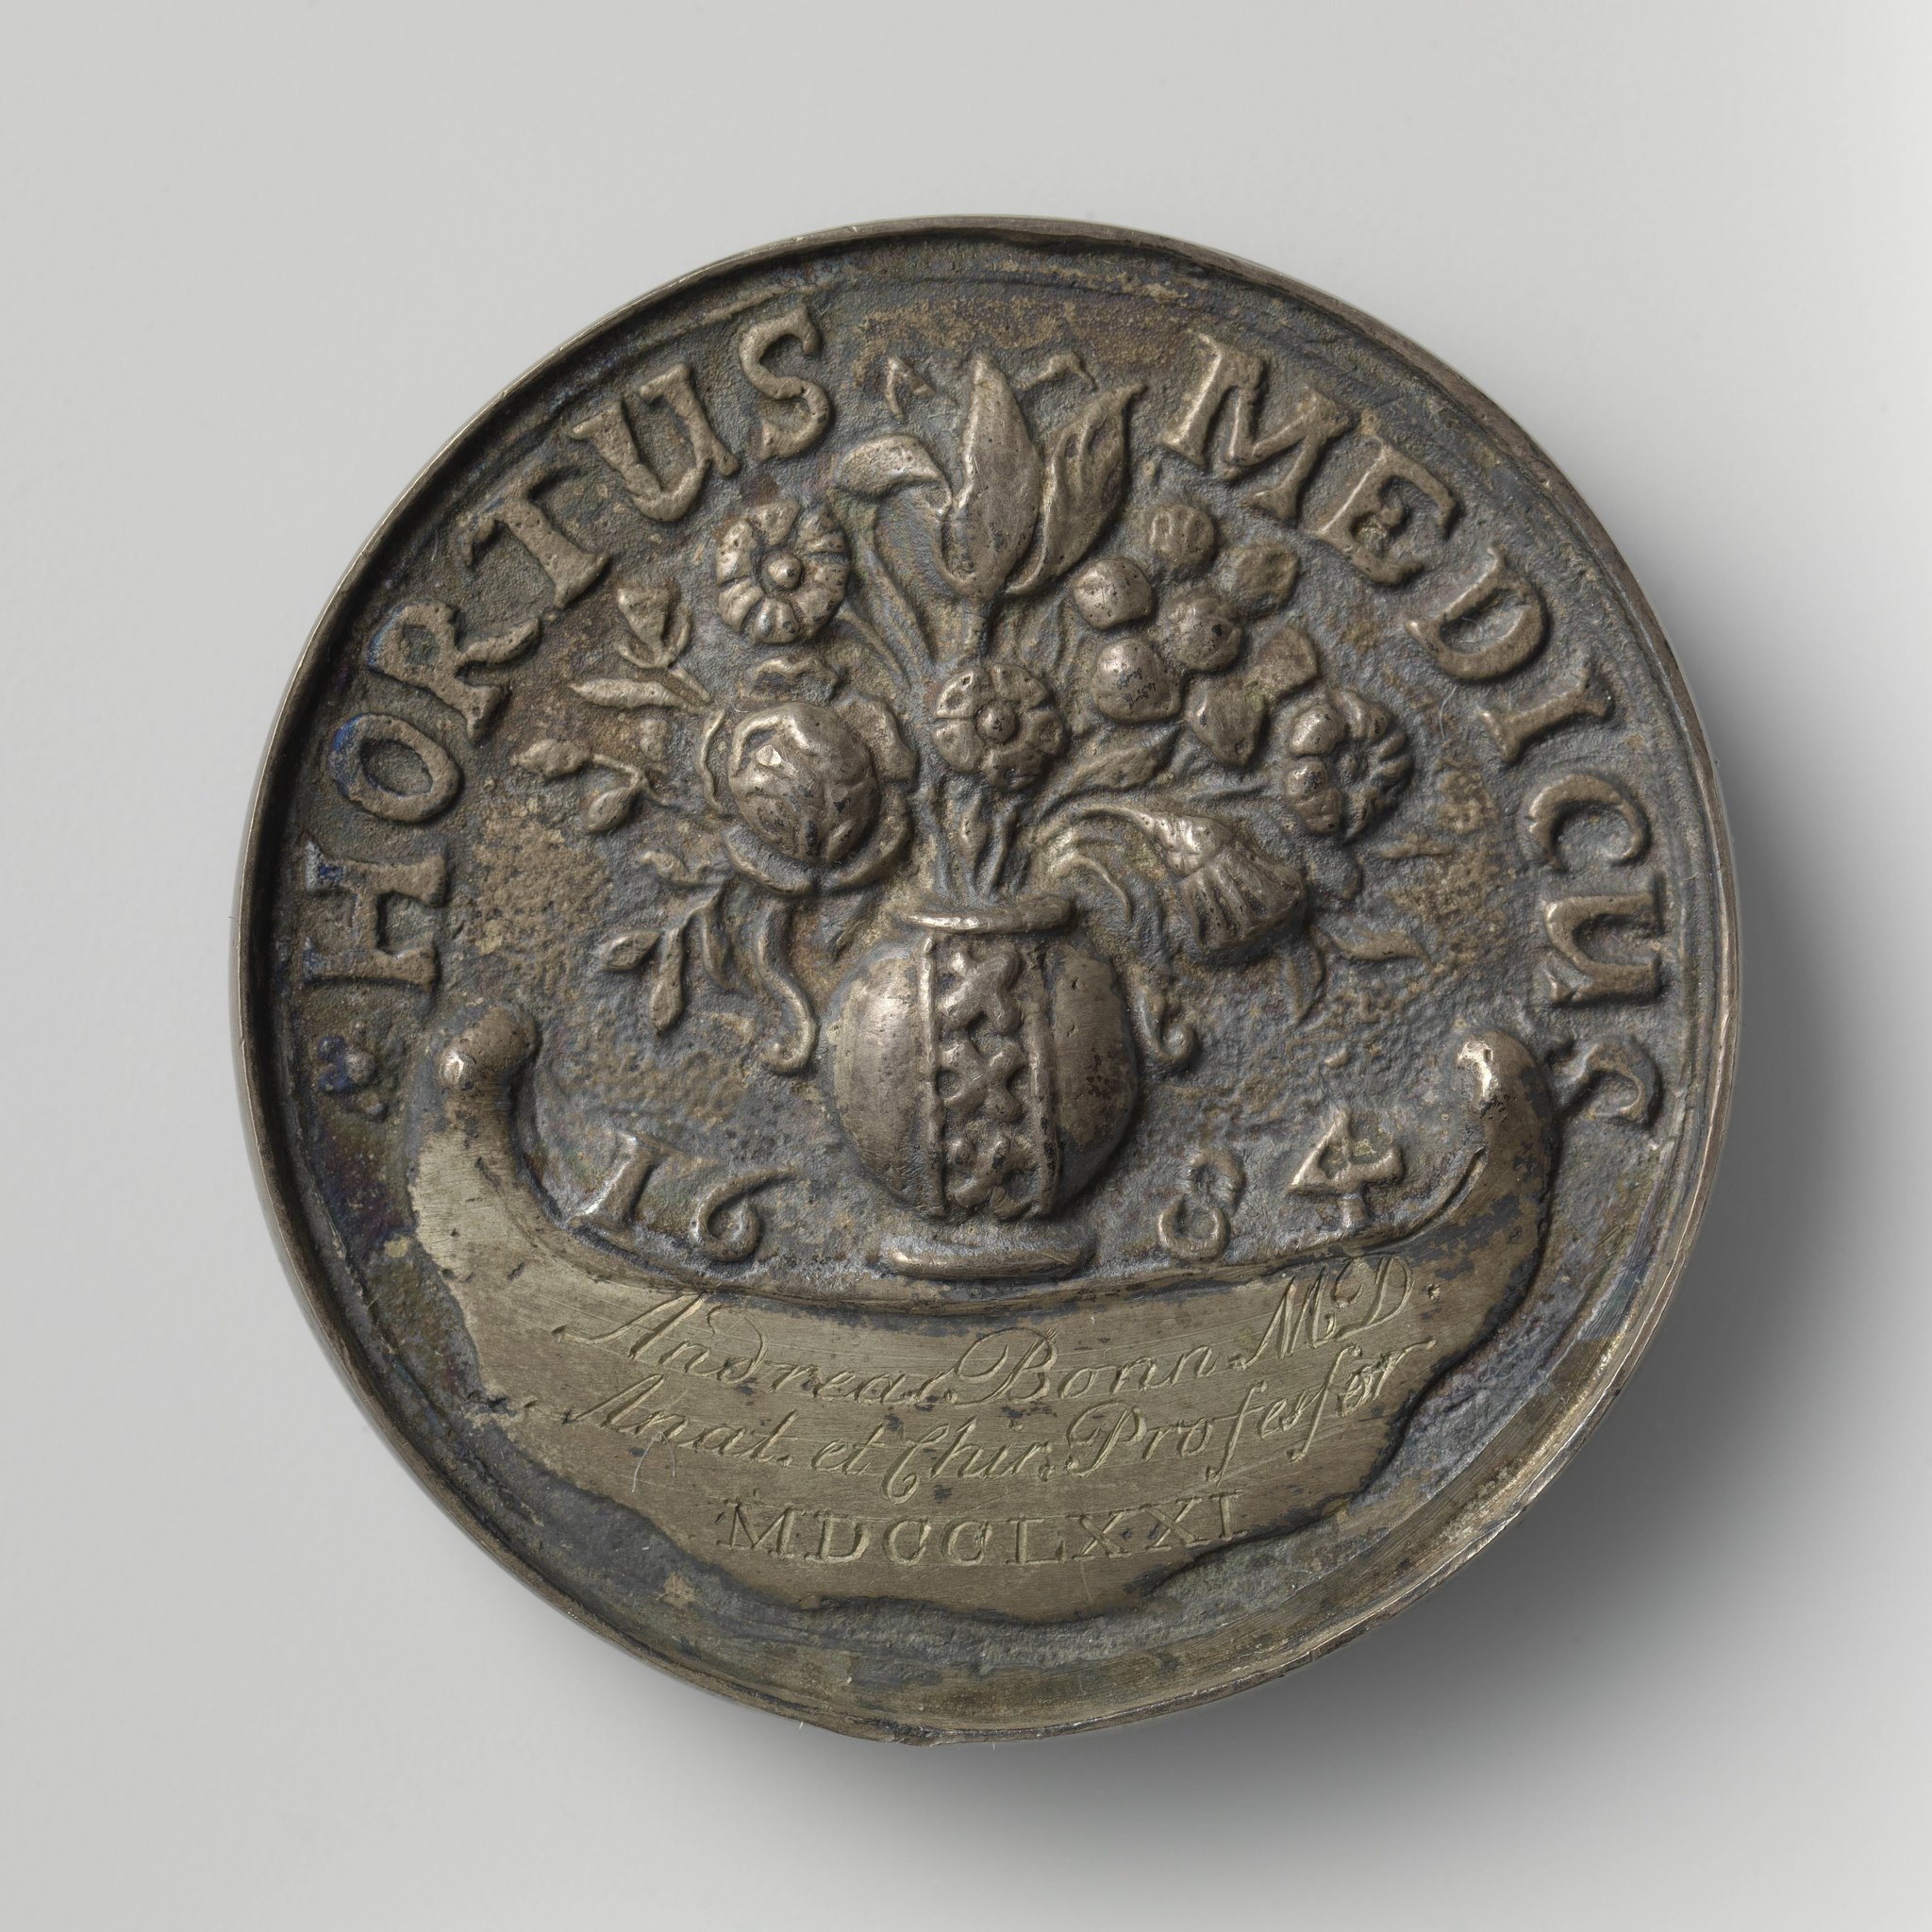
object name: medal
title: Chirurgijnsgilde te Amsterdam, toegangspenning voor de hortus medicus van Andreas Bonn, professor in de anatomie en de chirurgie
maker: Anonymous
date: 1771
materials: silver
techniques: casting, engraving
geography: amsterdam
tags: amsterdam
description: Zilveren penning. Voorzijde: Dood, afgebeeld als geraamte, in bloemenveld met zeis in rechterhand en met linkerhand op zandloper, die op sokkel staat. Keerzijde: vaas met bloemen tussen jaartal; op vaas: wapenschild boven cartouche binnen omschrift